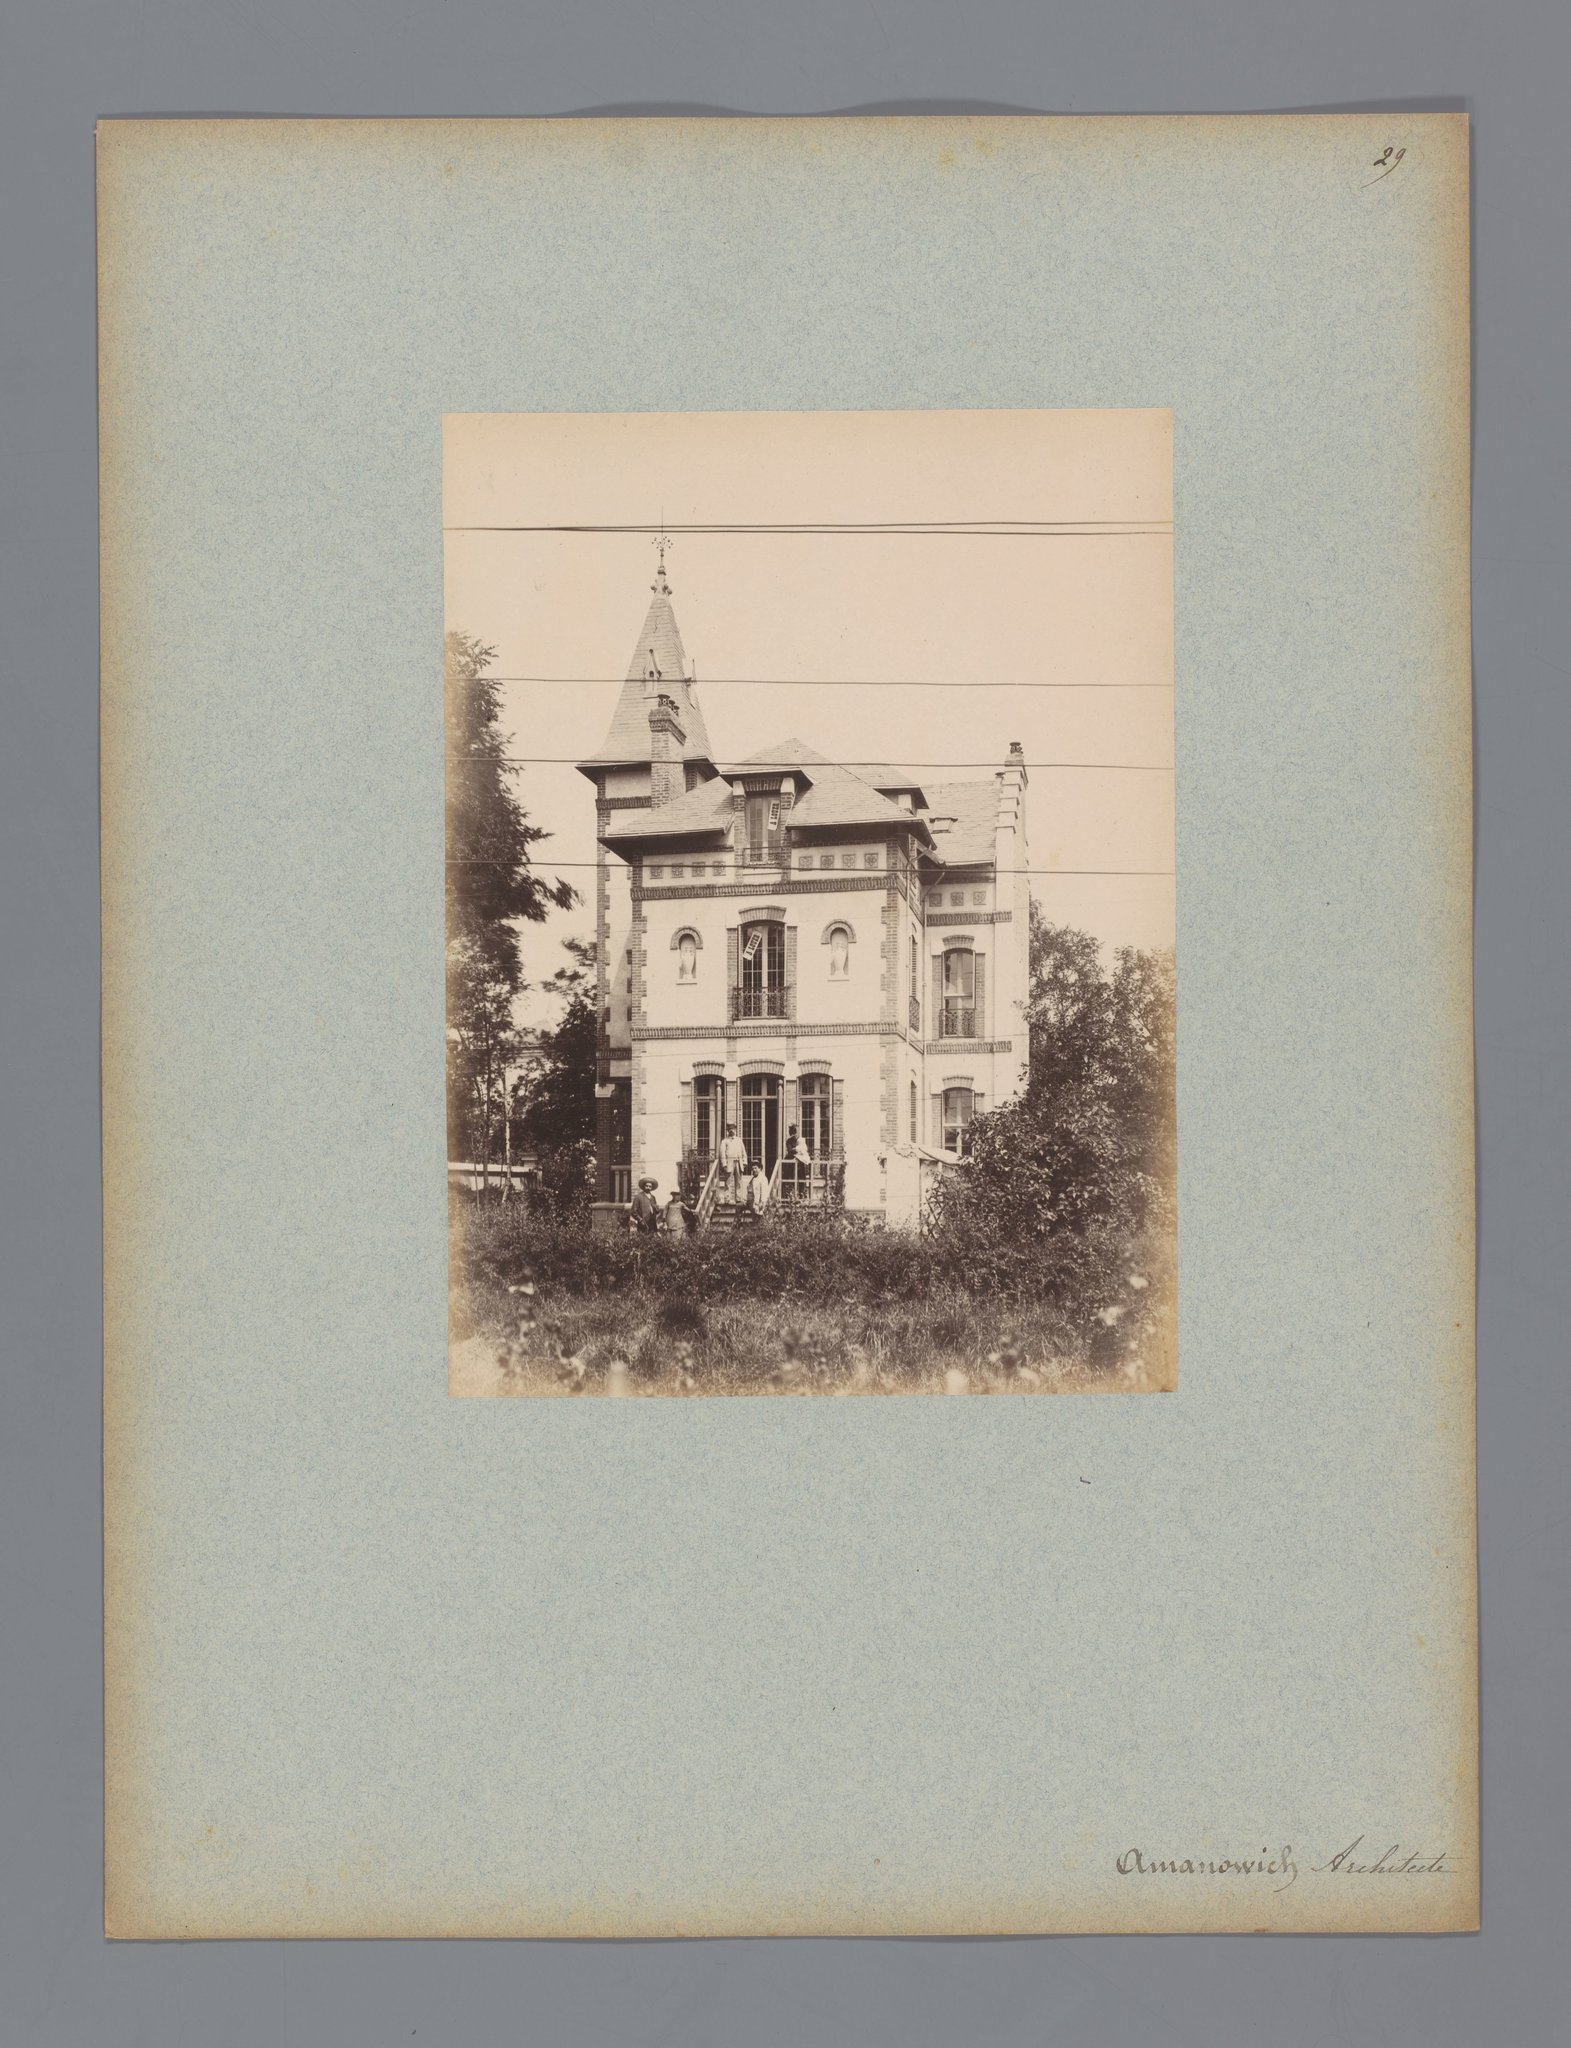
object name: photograph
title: Villa in Parijs, ontworpen door J. Amanowich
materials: photographic support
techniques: albumen print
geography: paris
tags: detached house in city, paris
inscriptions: number: ‘29’, name: ‘Amanowich Architecte’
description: Deze foto maakt deel uit van een omslag met 35 foto's en een titelblad.